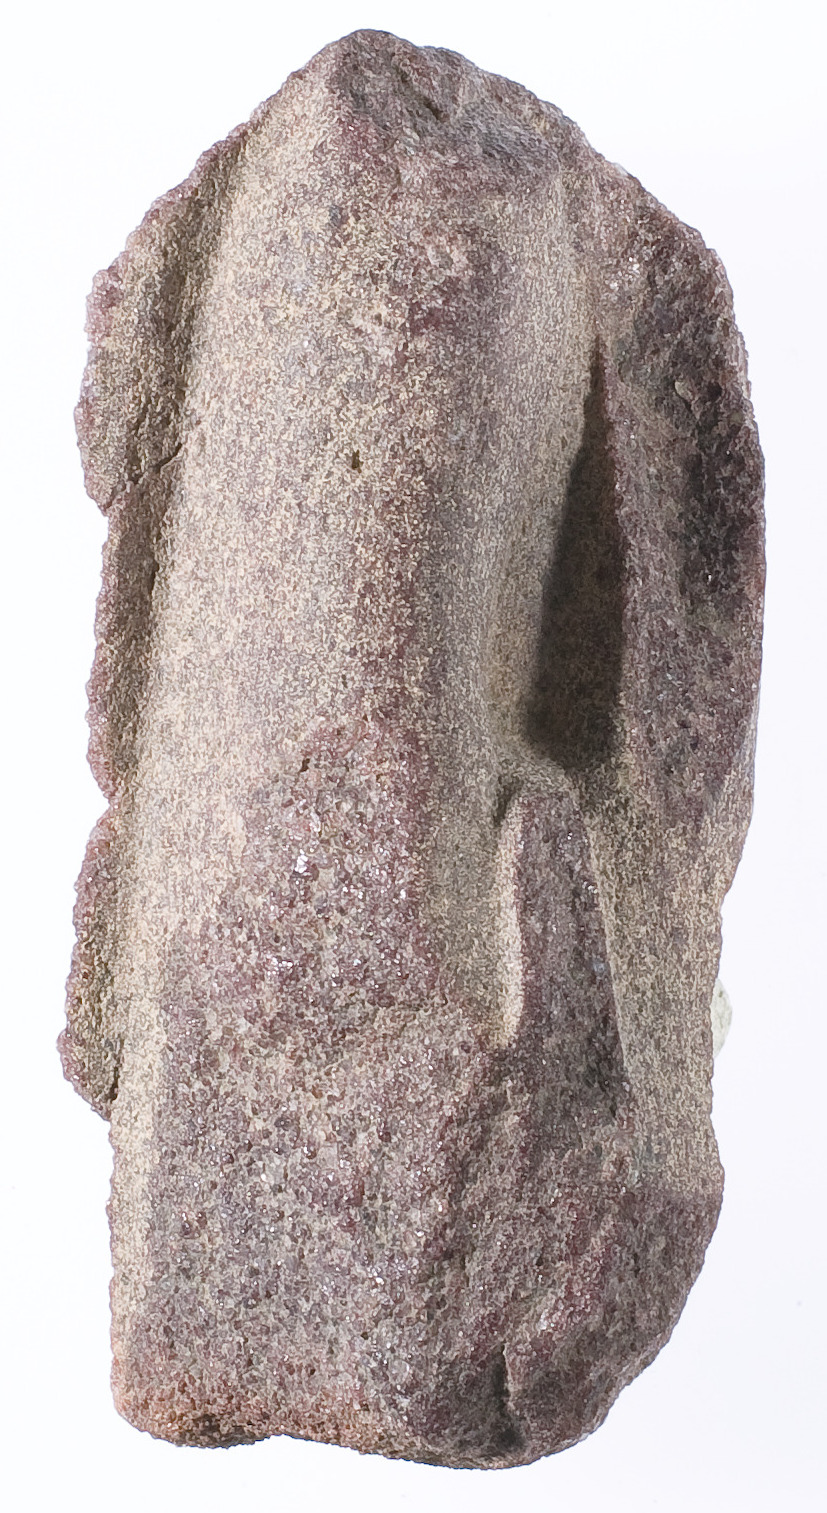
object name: toe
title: Right big toe with indication of a sandal strap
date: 1353-1336 BCE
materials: quartzite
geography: egypt